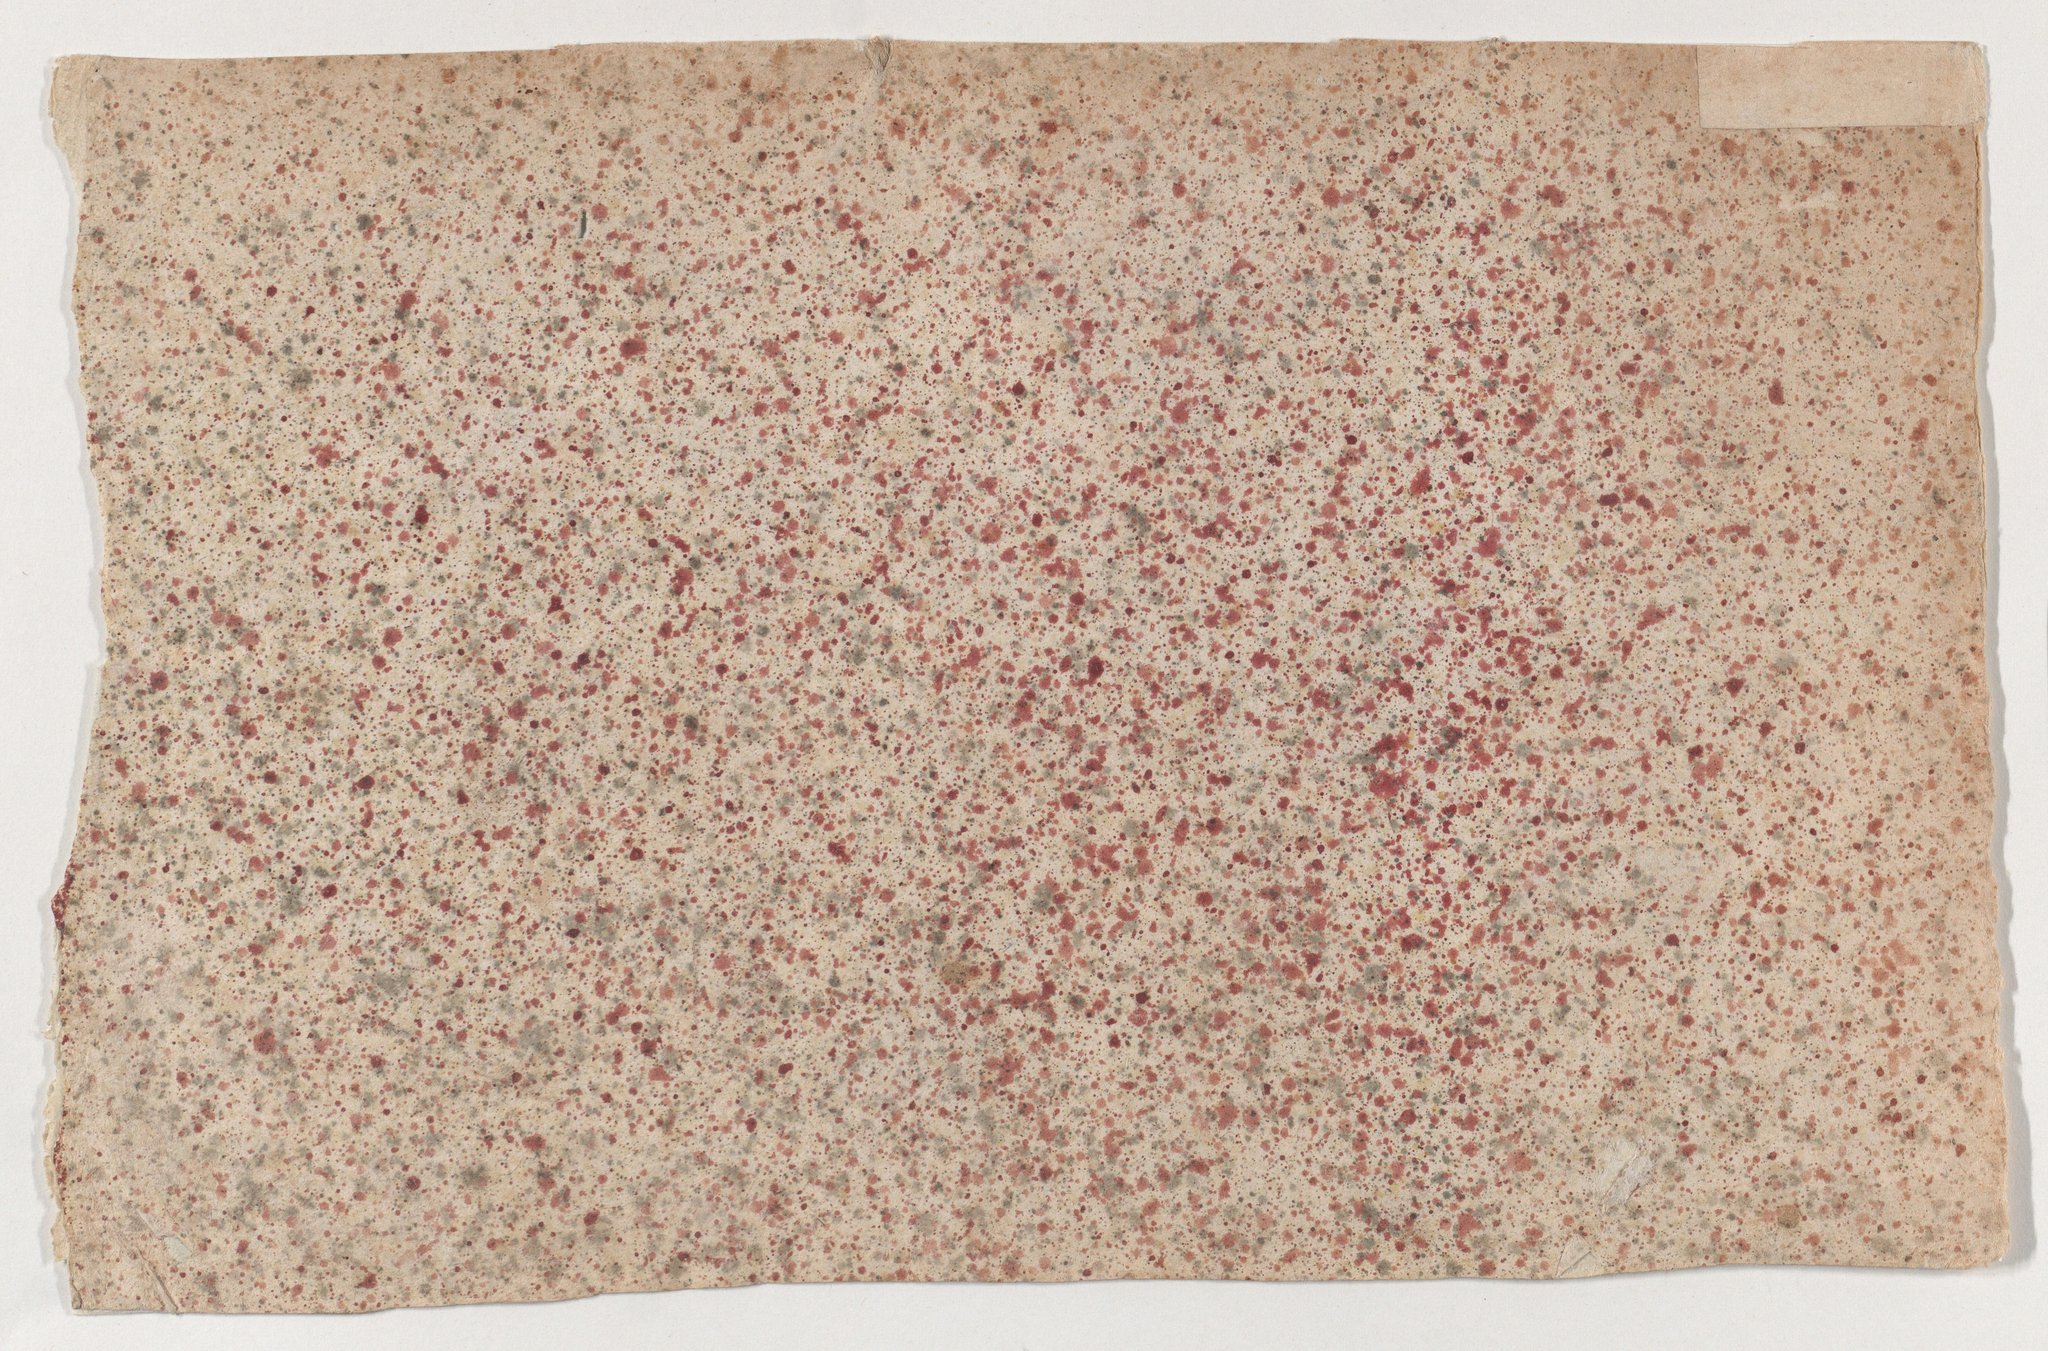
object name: print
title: Sheet with an overall red speckle pattern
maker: Anonymous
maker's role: artist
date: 1801-1900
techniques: relief print